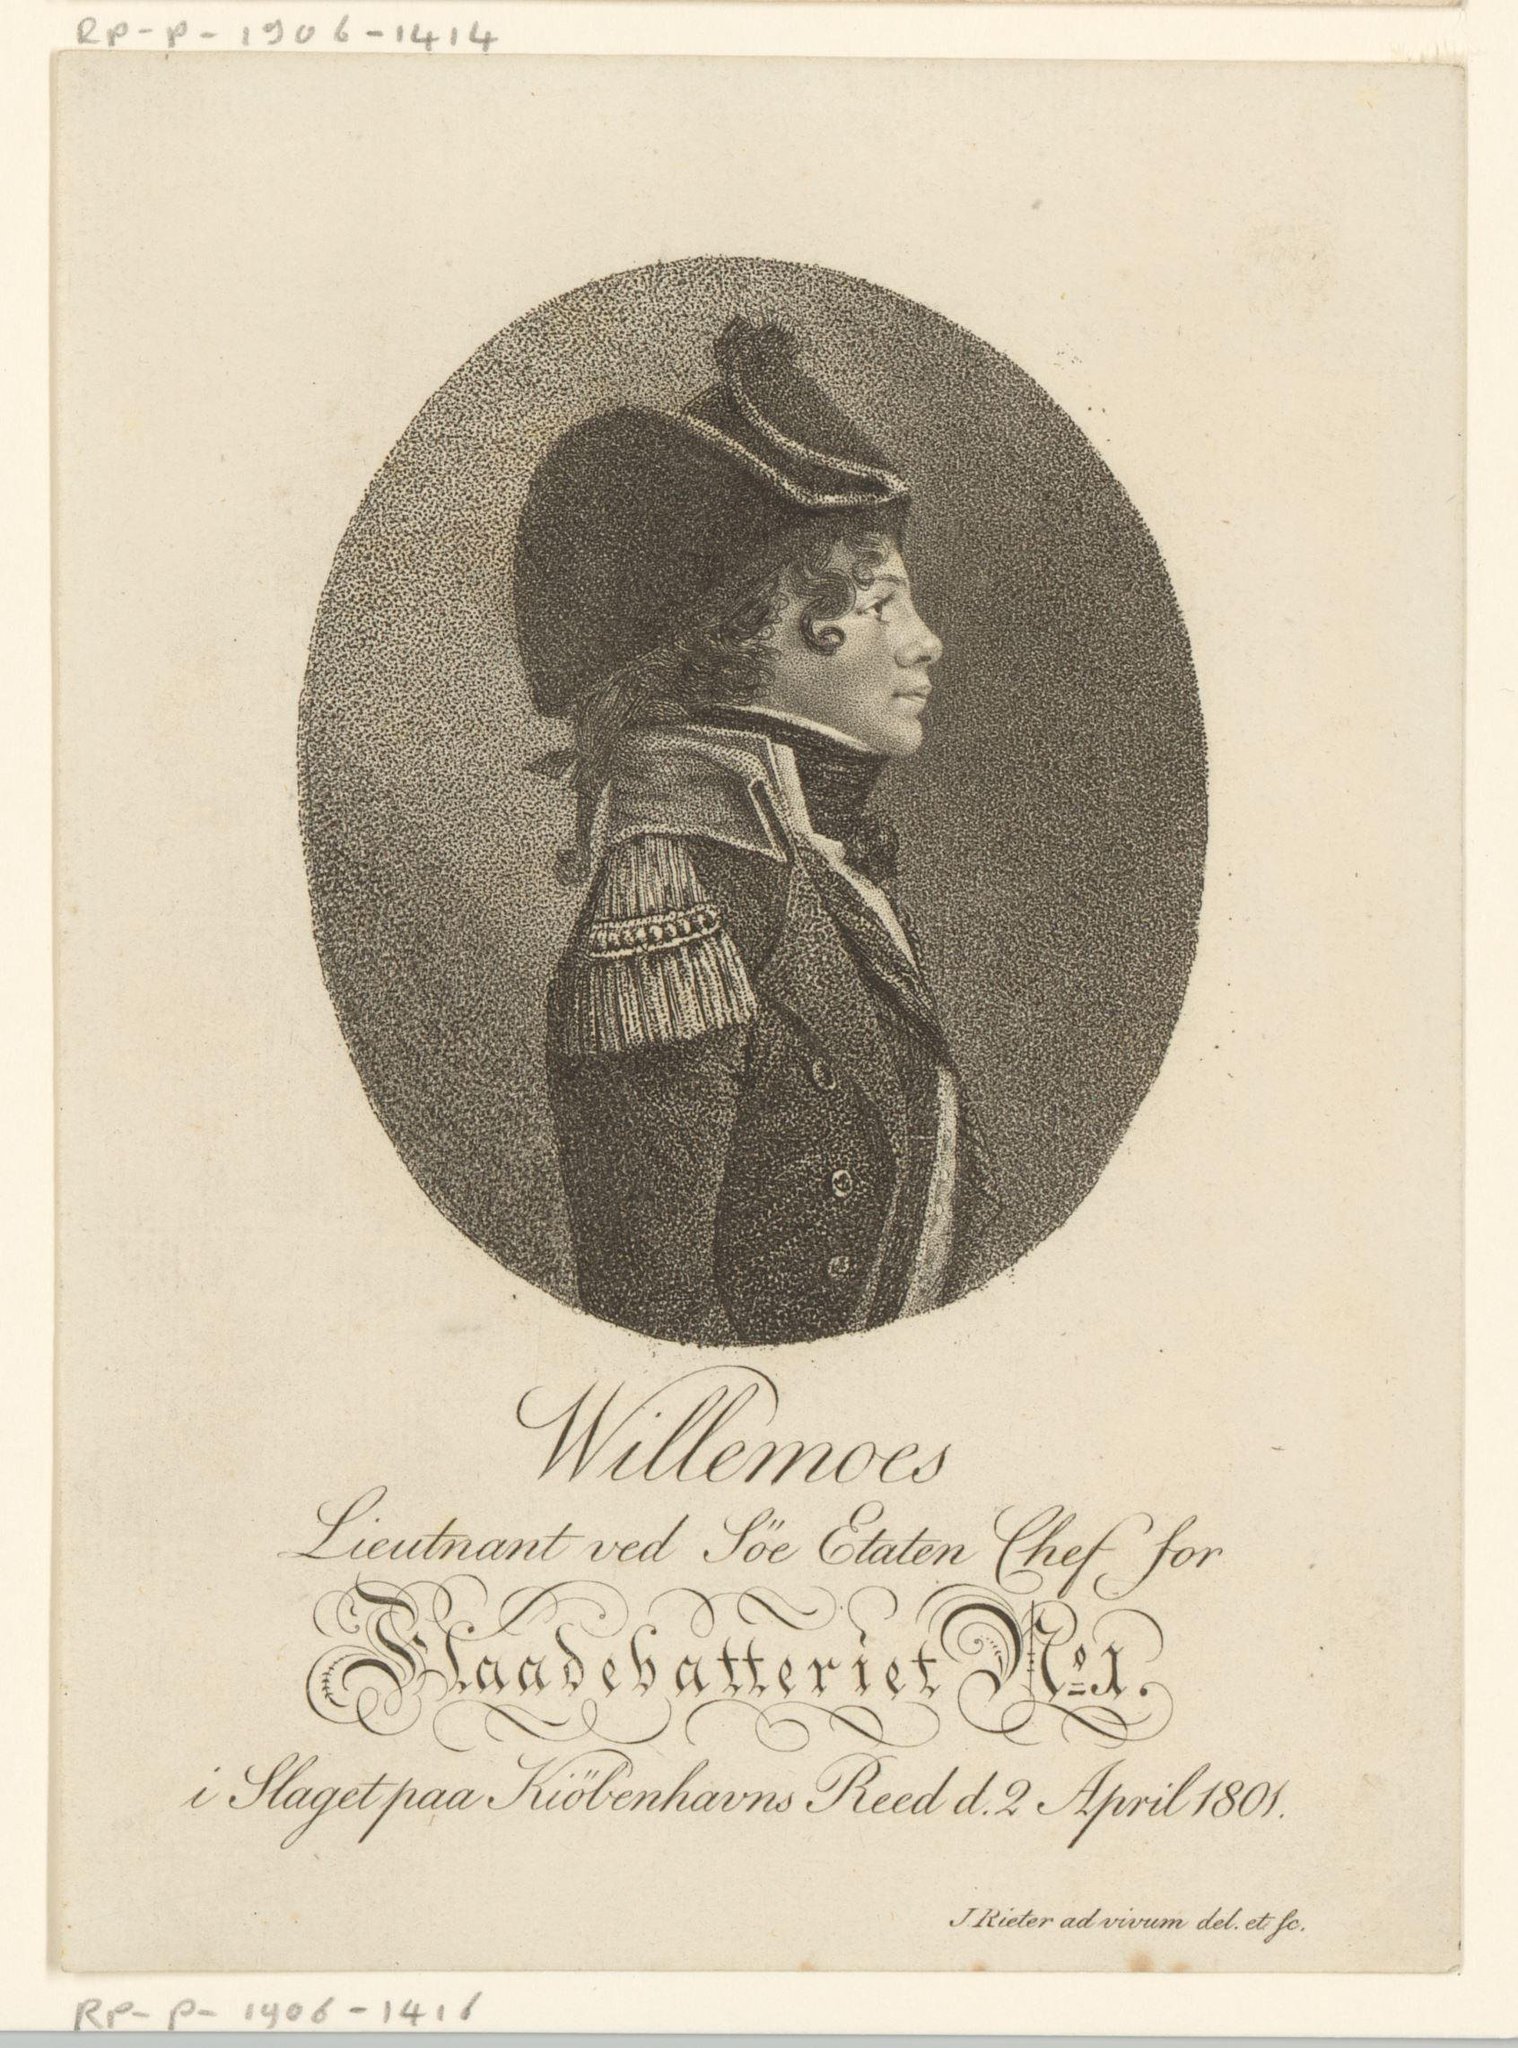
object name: print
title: Portret van Willemoes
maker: johann jakob rieter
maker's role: print maker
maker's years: 1758-1823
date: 1801-1823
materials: paper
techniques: engraving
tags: copenhagen (city), historical persons, the soldier; the soldier's life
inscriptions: collector's mark: Lugt 2228